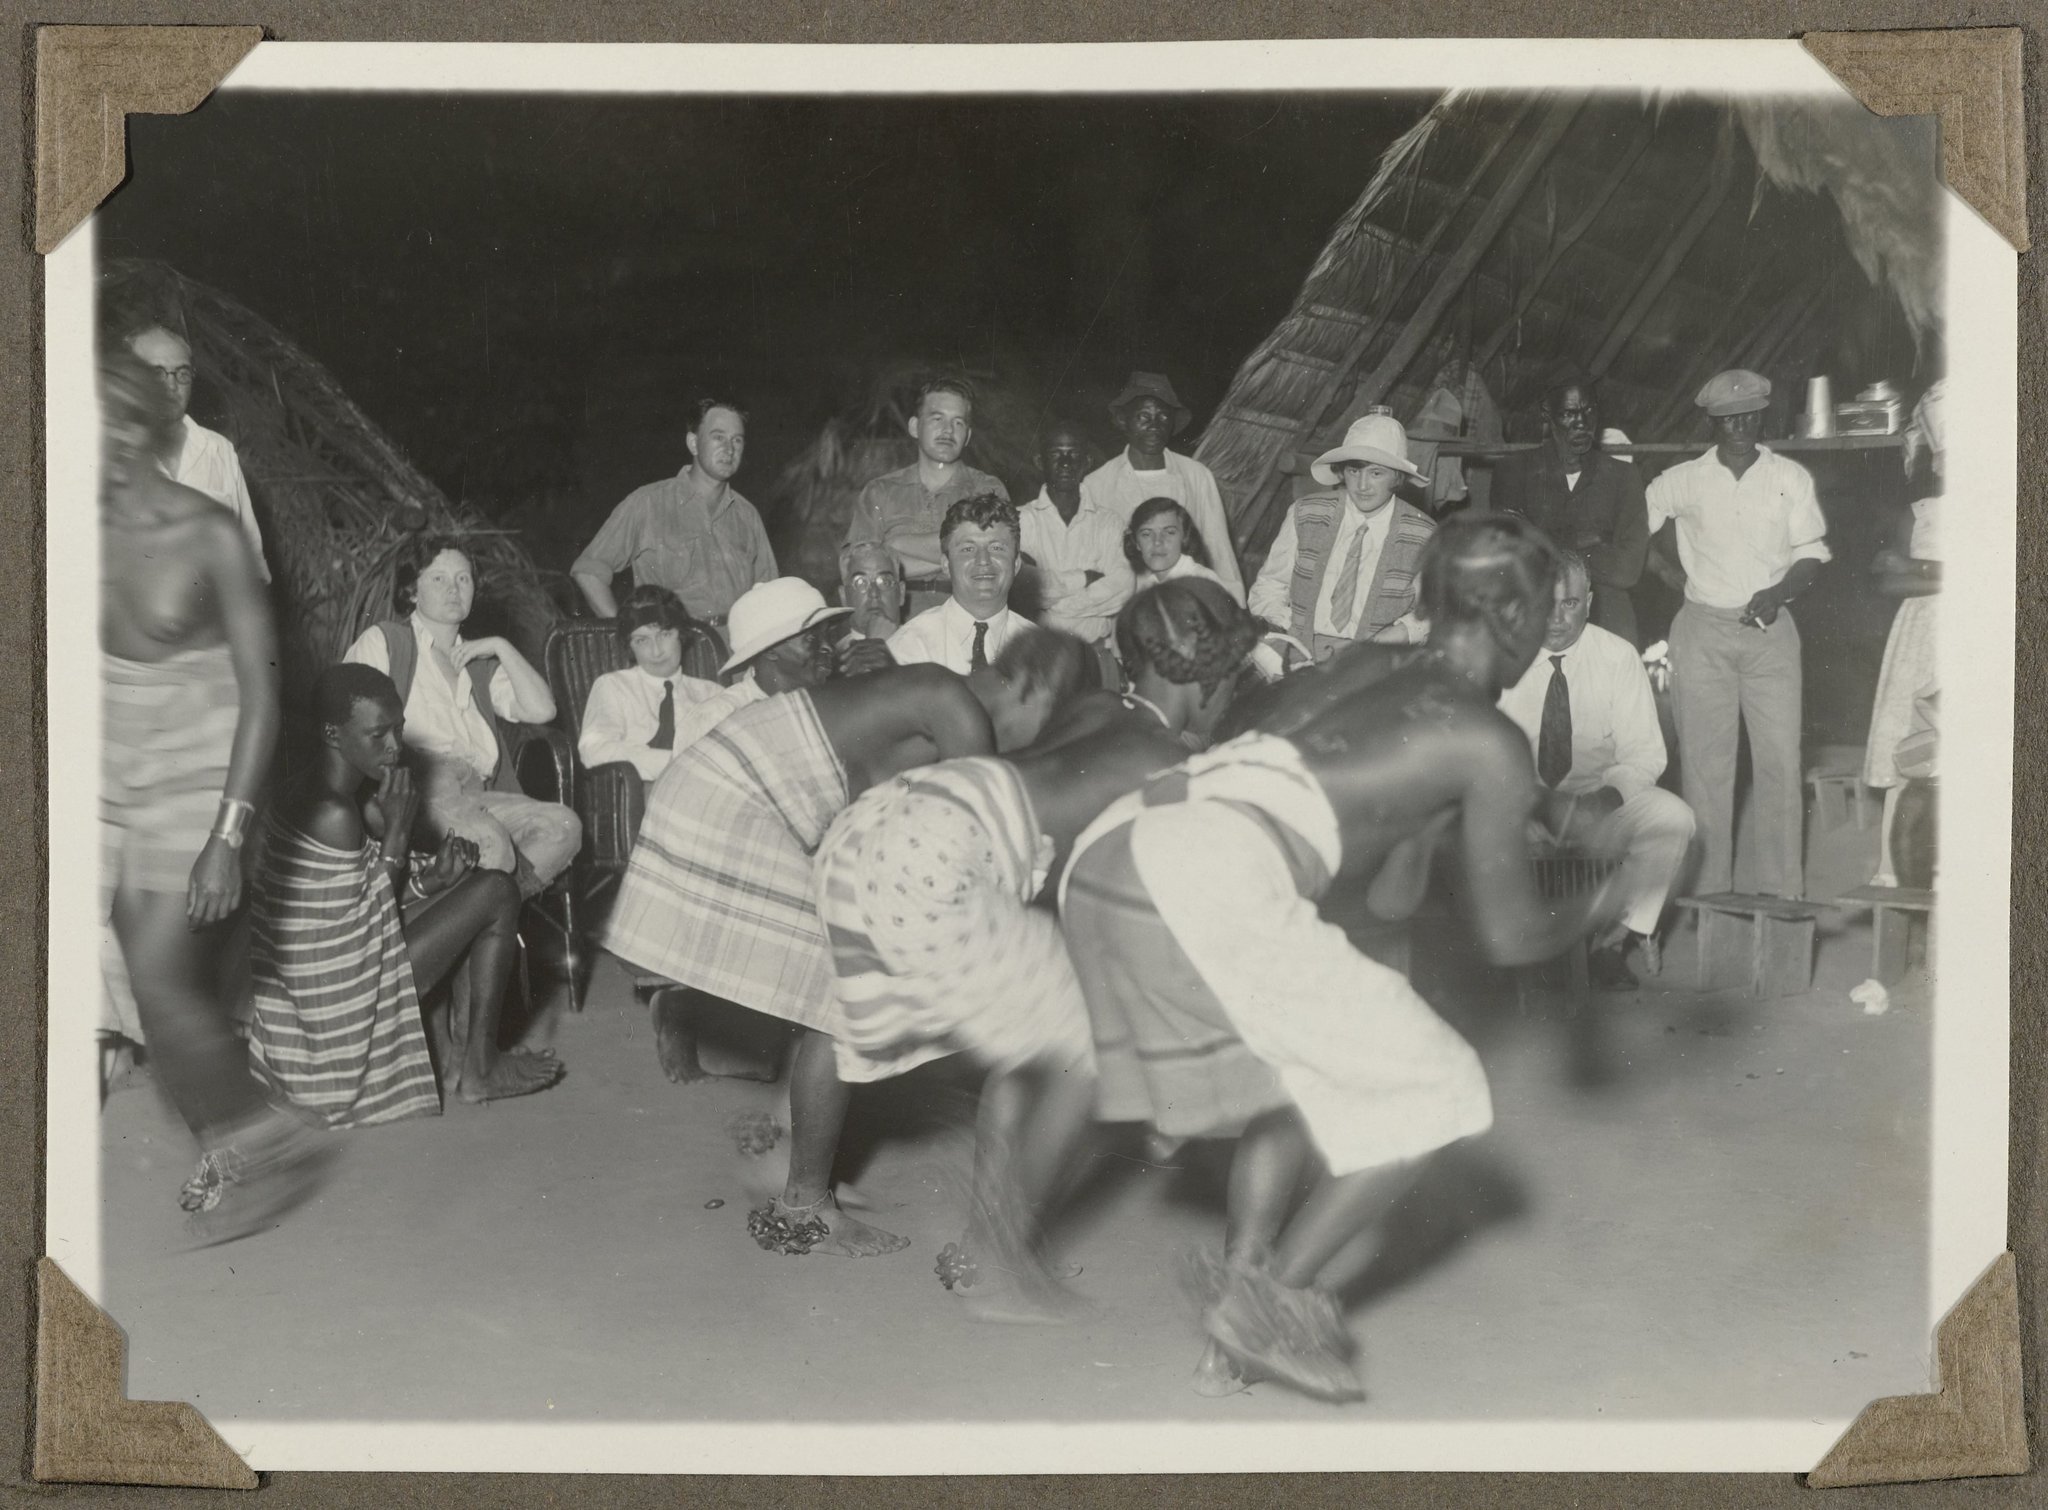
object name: photograph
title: Dansende Marron vrouwen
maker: Anonymous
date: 1925-1927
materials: photographic support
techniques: photography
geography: suriname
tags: group of women (folk dancing), suriname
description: Dansende Marron vrouwen in een dorp bezocht door een groep Nederlanders waaronder het echtpaar Jetten. Foto met hoekjes bevestigd op een bladzijde van een albumblad in het fotoalbum over de familie Jetten en het leven en werken in de mijnstad Moengo in Suriname rond 1927.